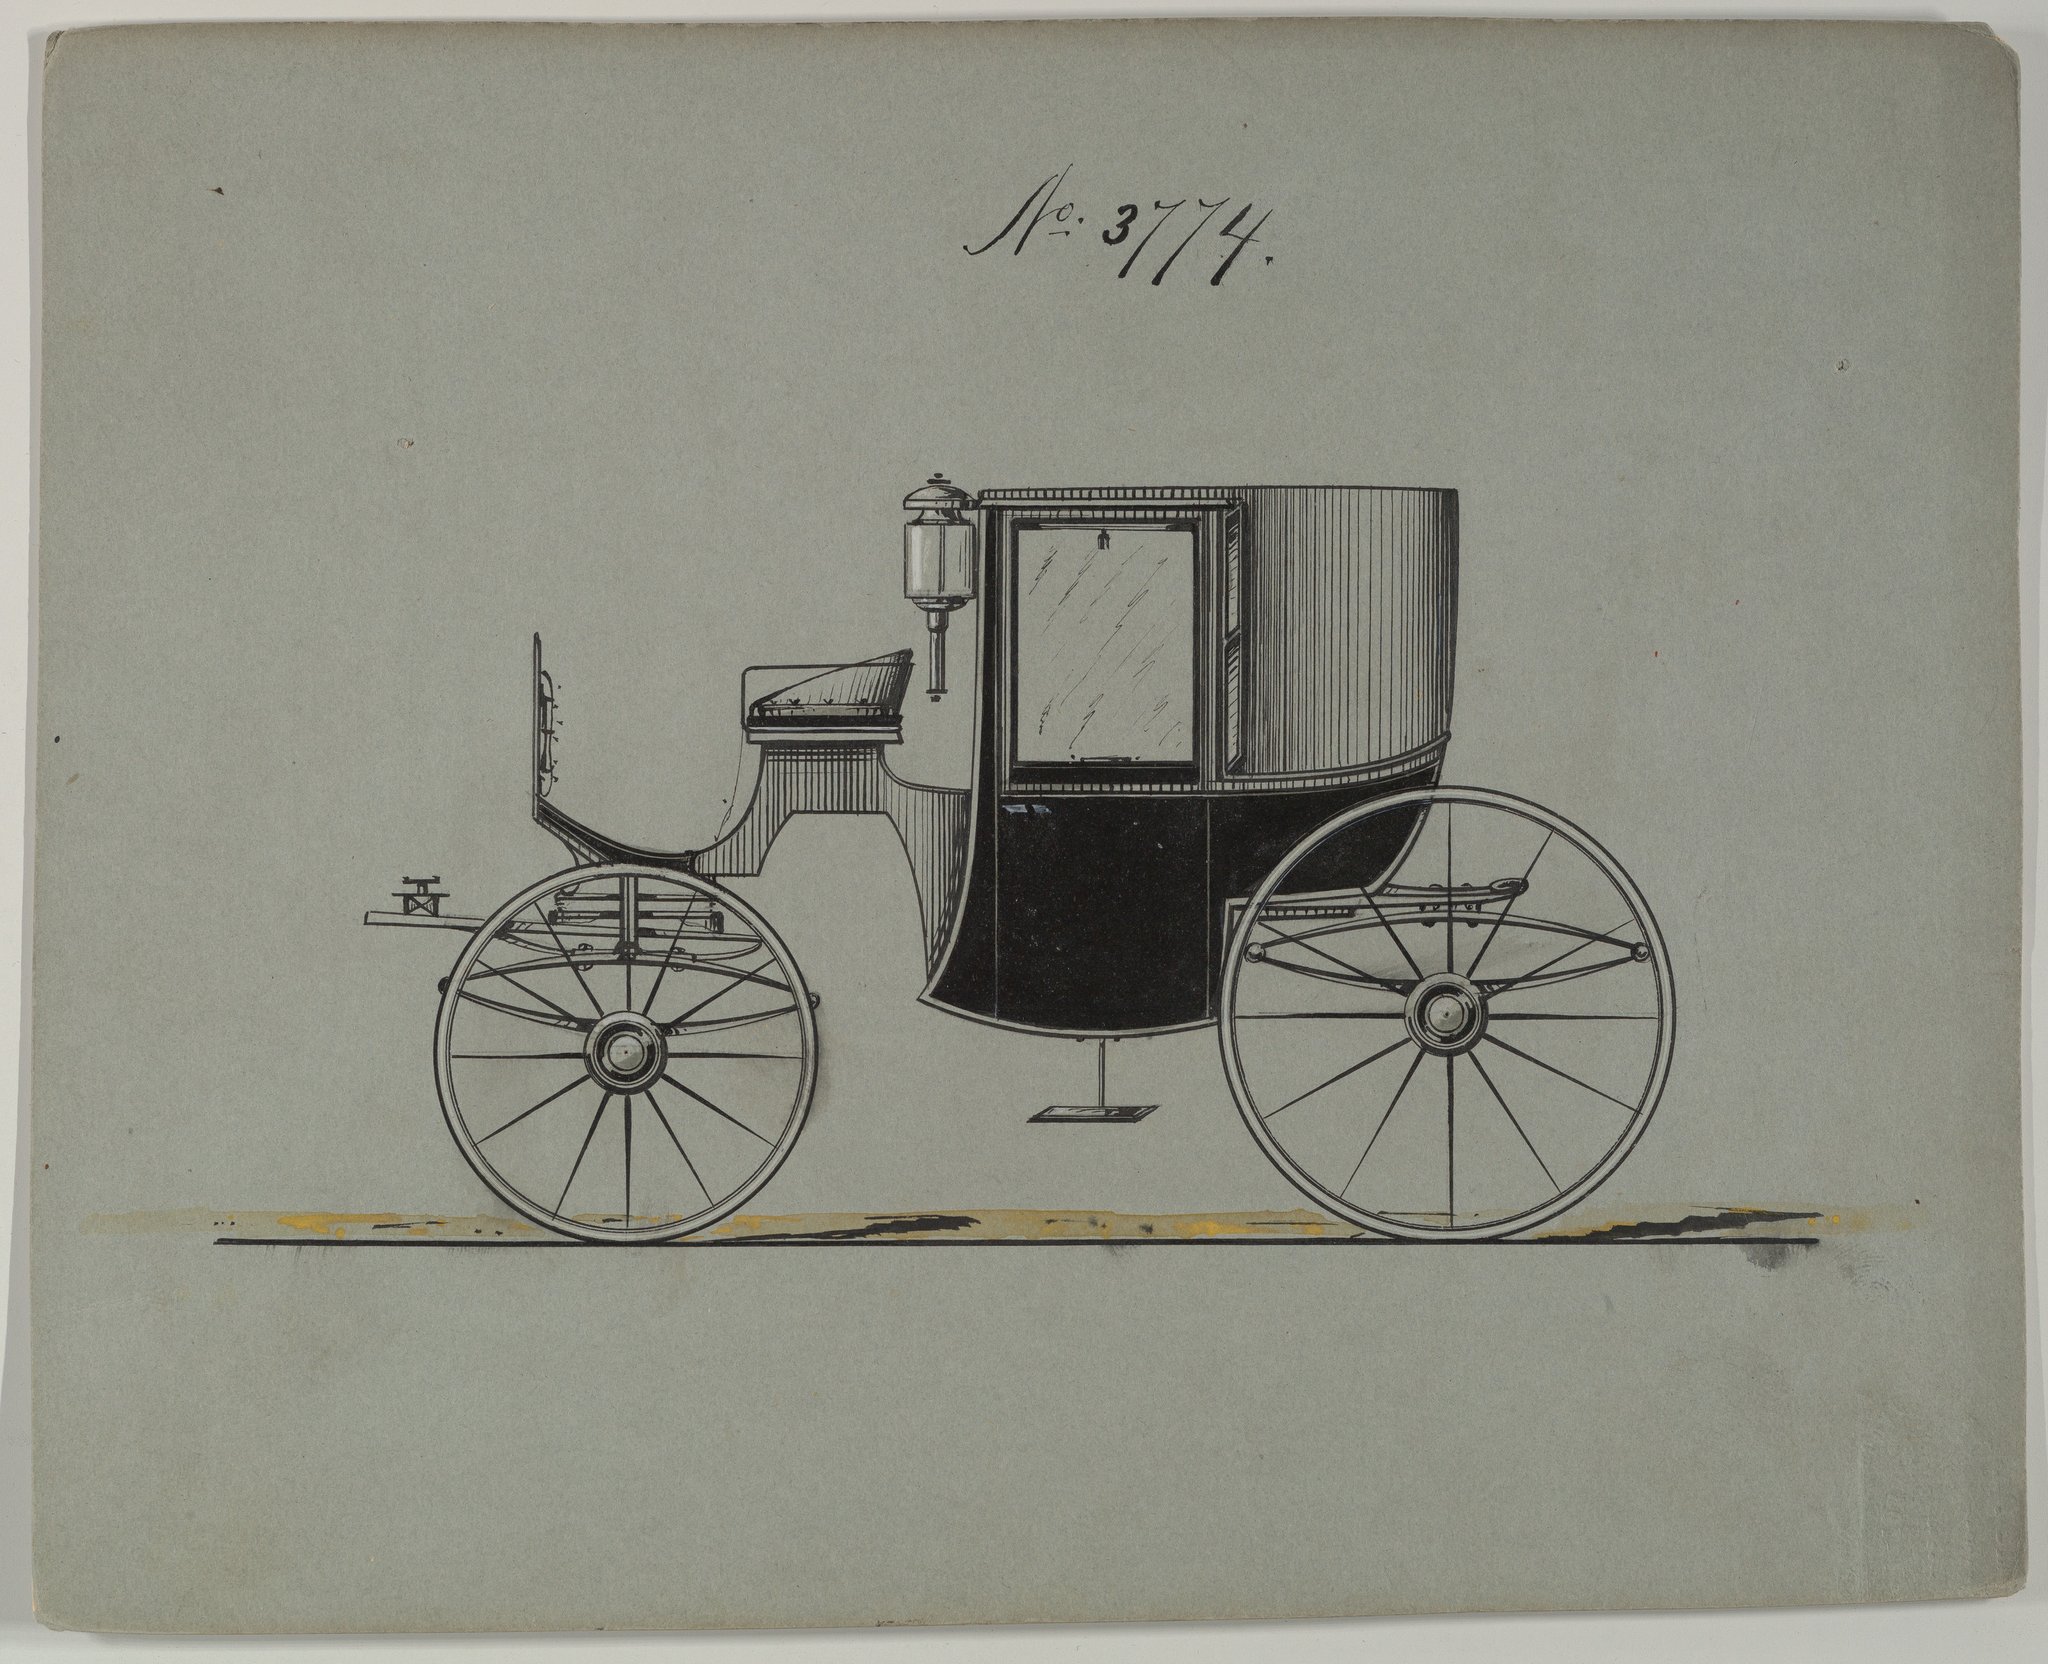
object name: drawing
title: Brougham #3774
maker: brewster & co.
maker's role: manufacturer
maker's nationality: american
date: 1882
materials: gouache, ink, watercolor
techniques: pen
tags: carriages